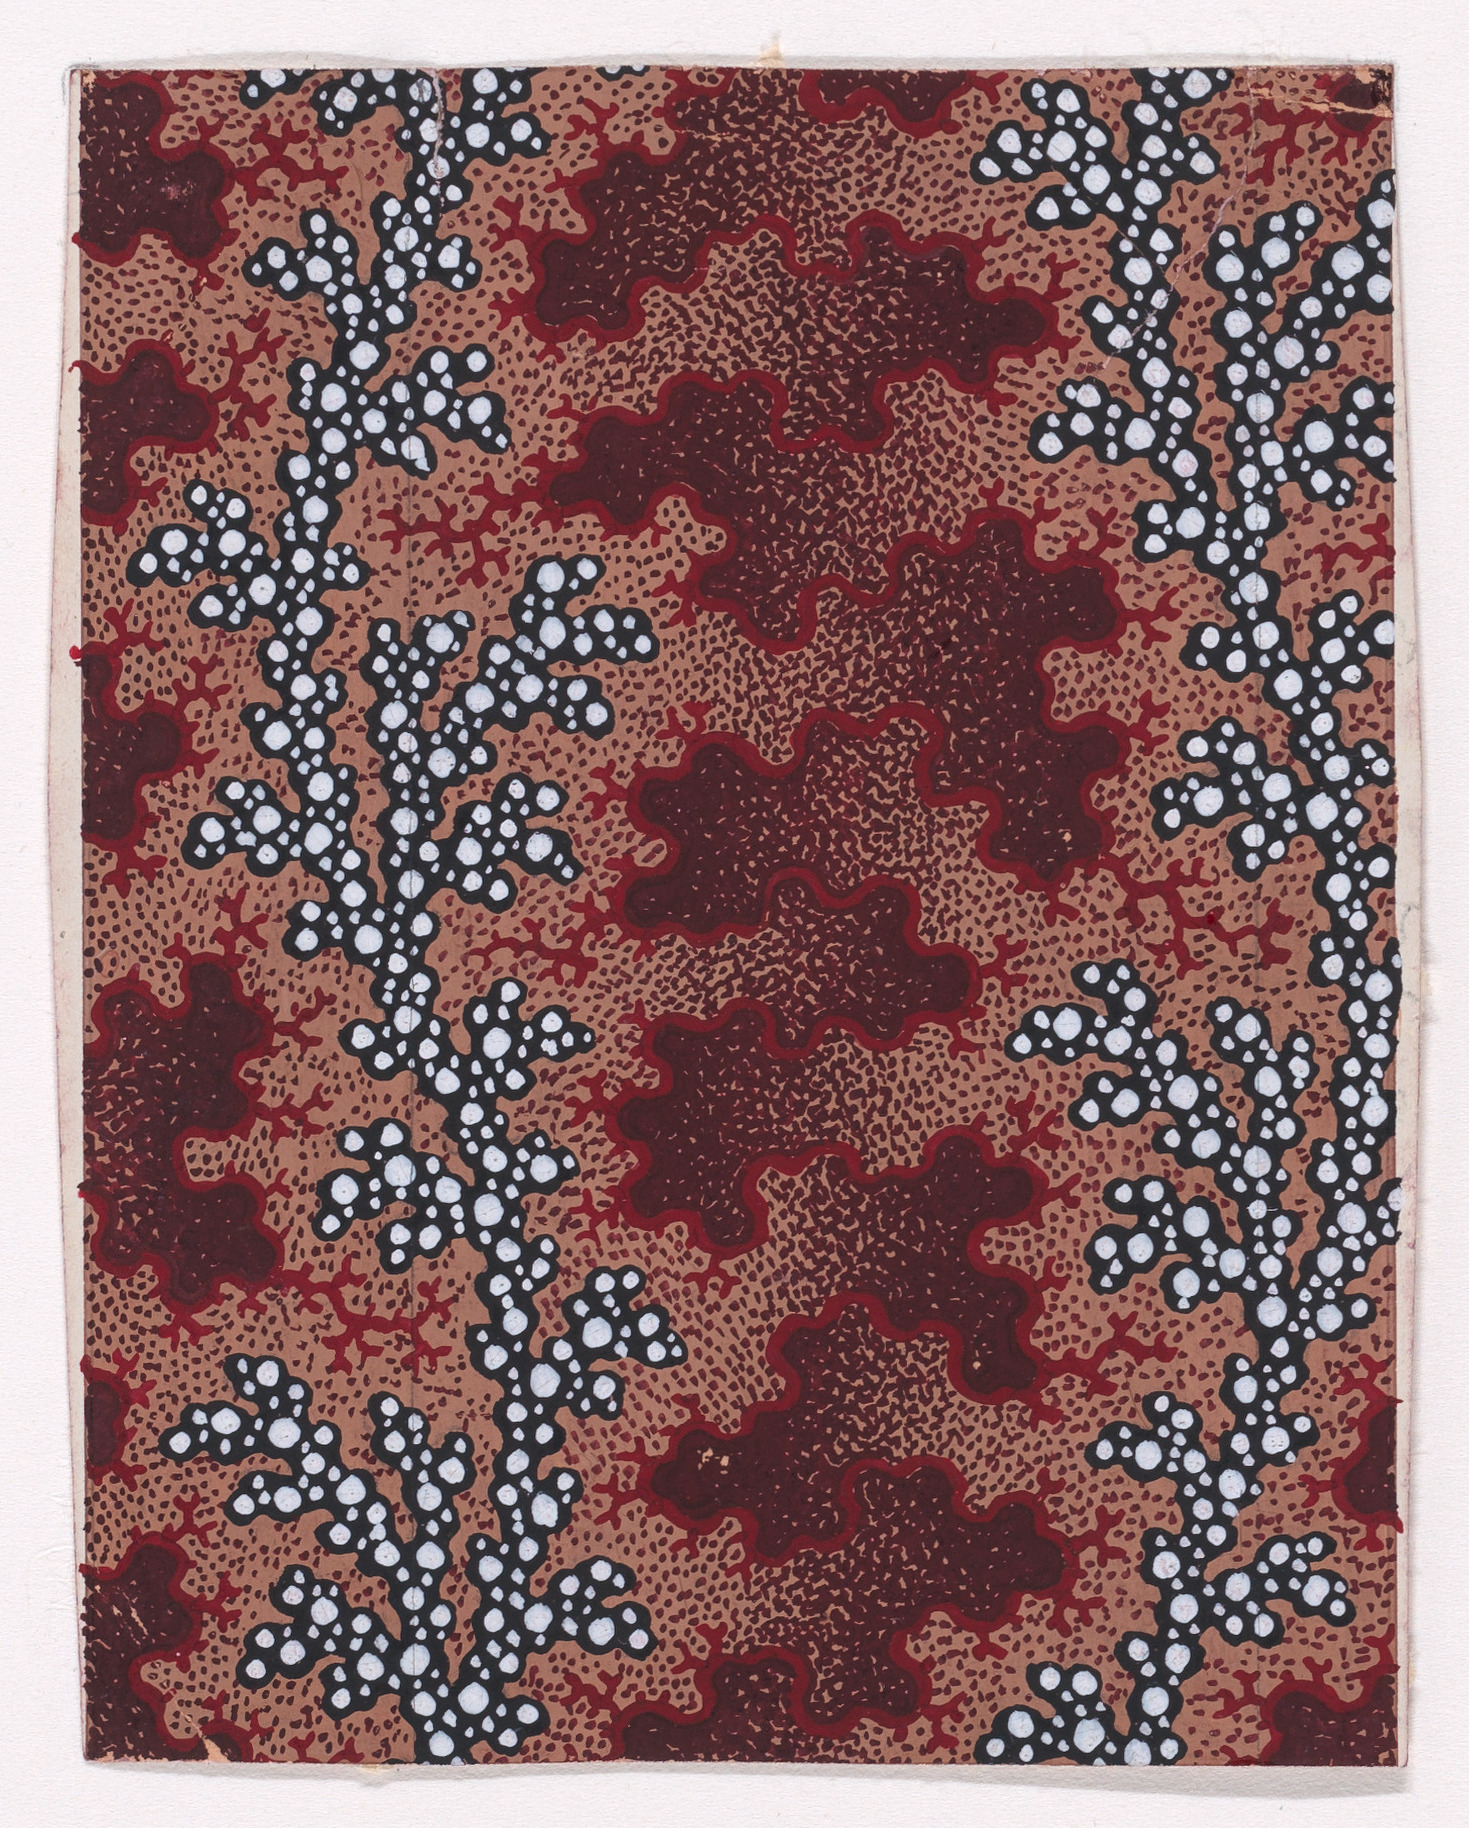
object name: drawing ornament architecture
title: Textile Design with Vertical Undulating Garlands of Pearls Separated by Vertical Strips of Vermicular Pattern over a Stippled Background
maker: anonymous, alsatian, 19th century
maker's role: artist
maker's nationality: alsatian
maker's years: 1800-1900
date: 1840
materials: gouache